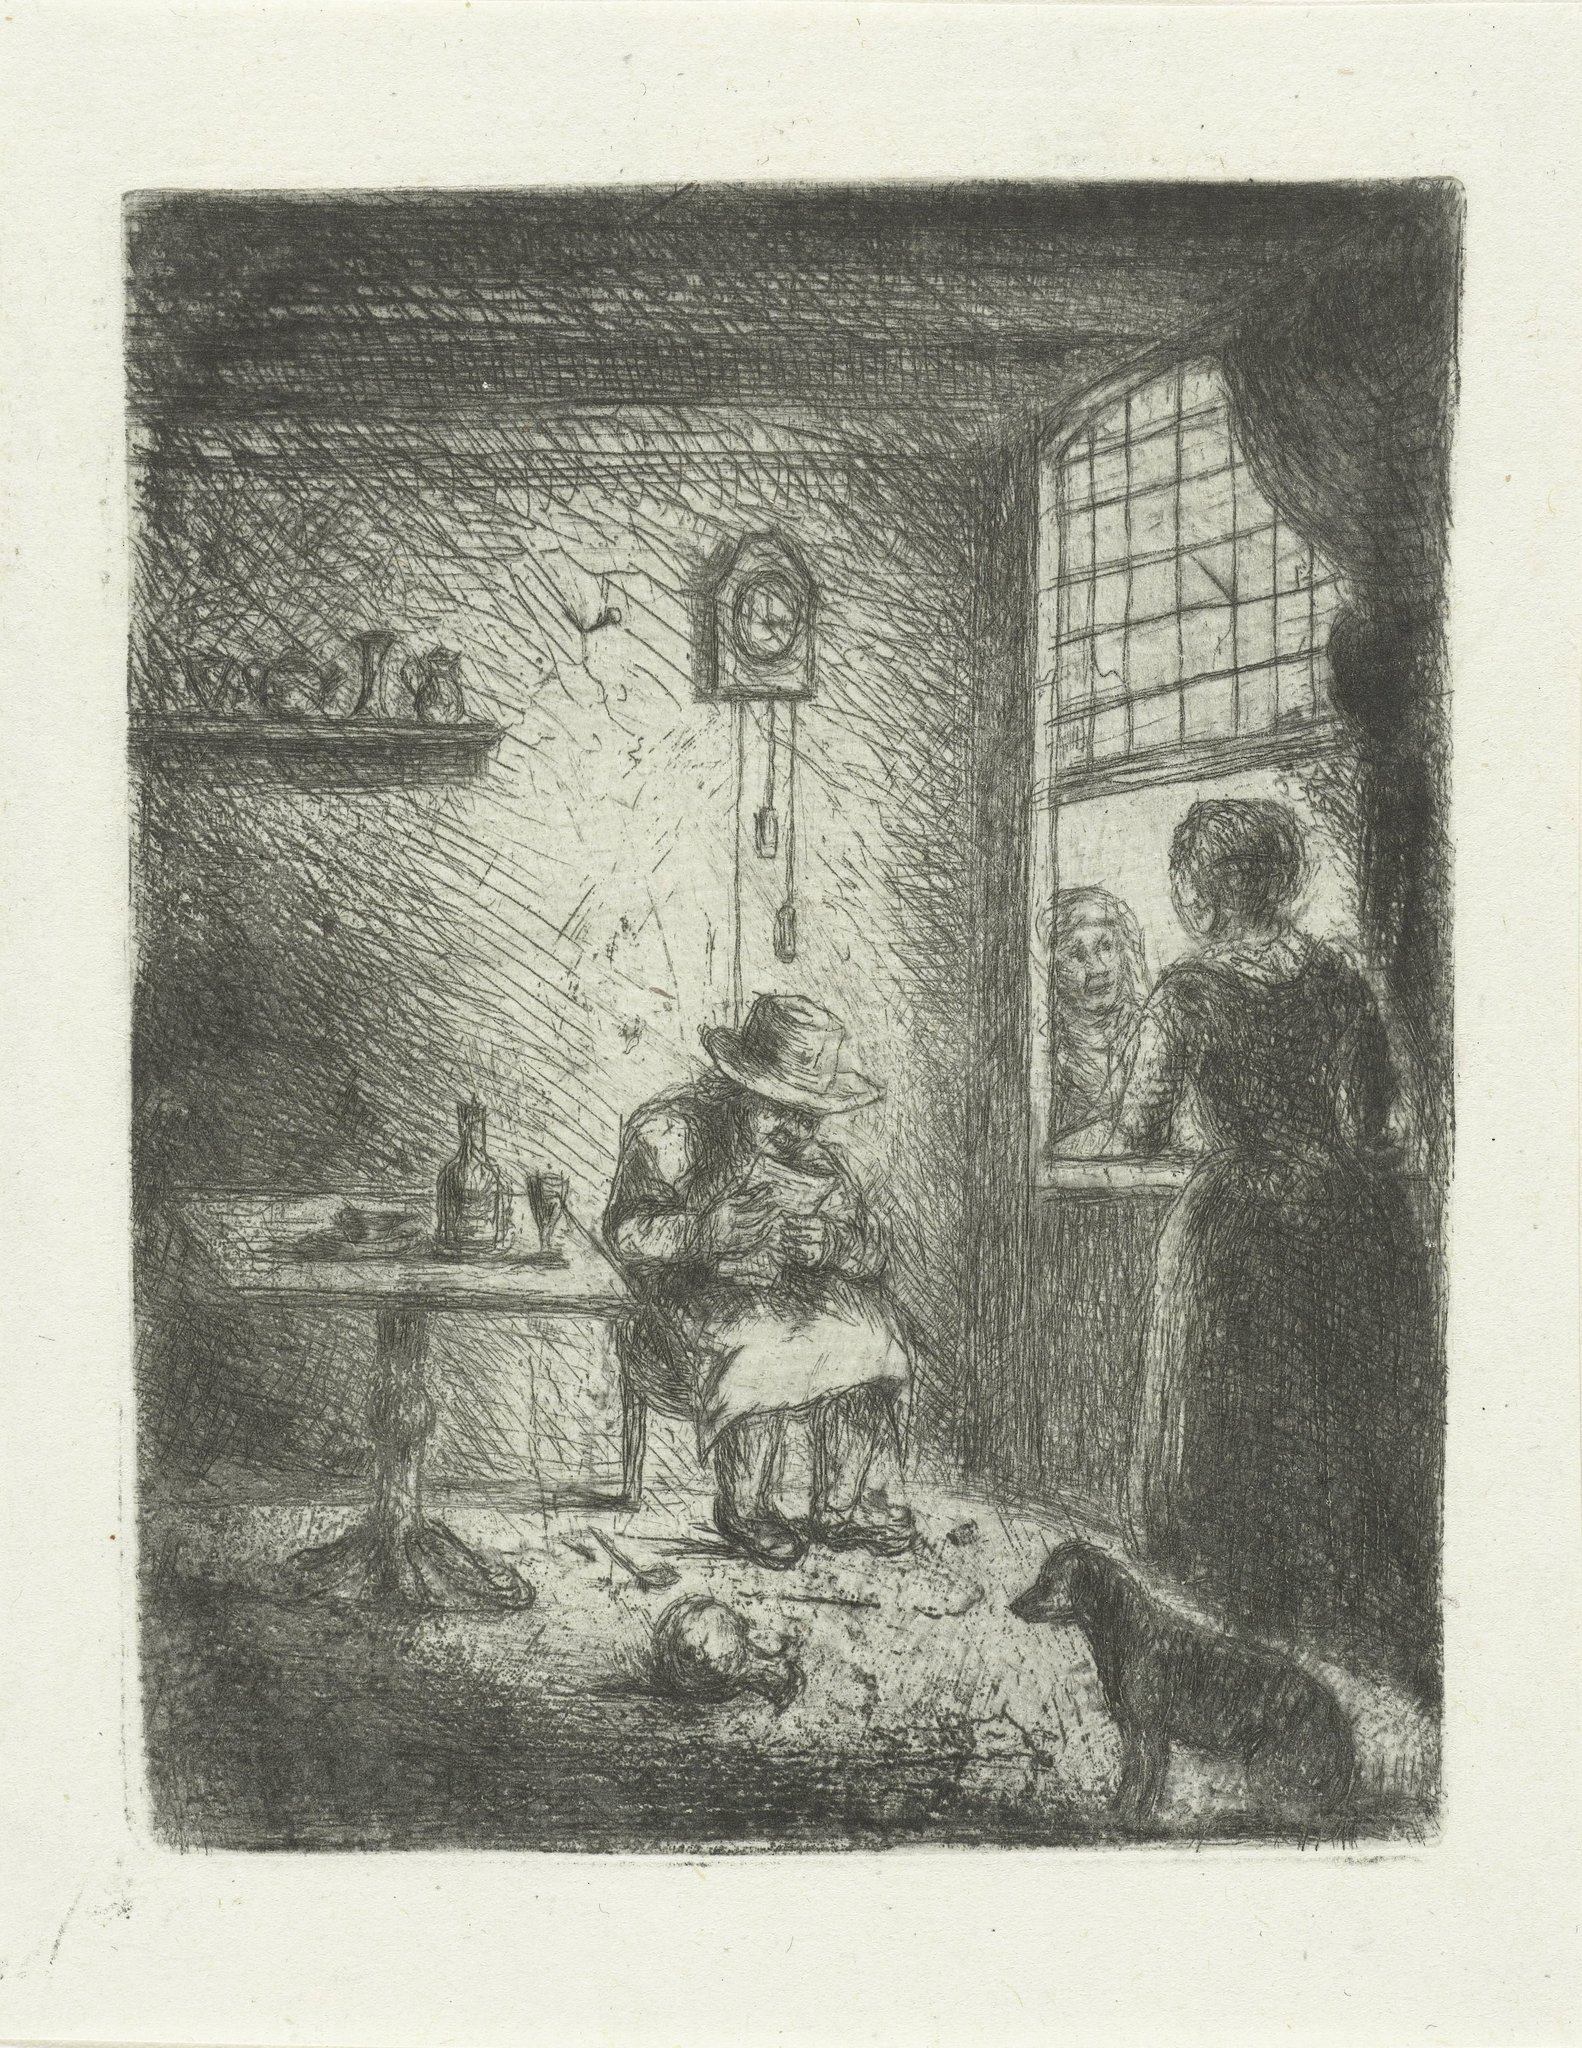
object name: print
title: Interieur met lezende man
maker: jan chalon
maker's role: print maker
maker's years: 1738-1795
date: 1748-1795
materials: paper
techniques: drypoint, etching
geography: northern netherlands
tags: reading, pamphlet ~ printed matter, living-room, parlour, sitting-room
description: Interieur van een huis. Een man zit op een stoel onder een wandklok en leest. Twee vrouwen praten met elkaar door een open raam. Een hond op de voorgrond.